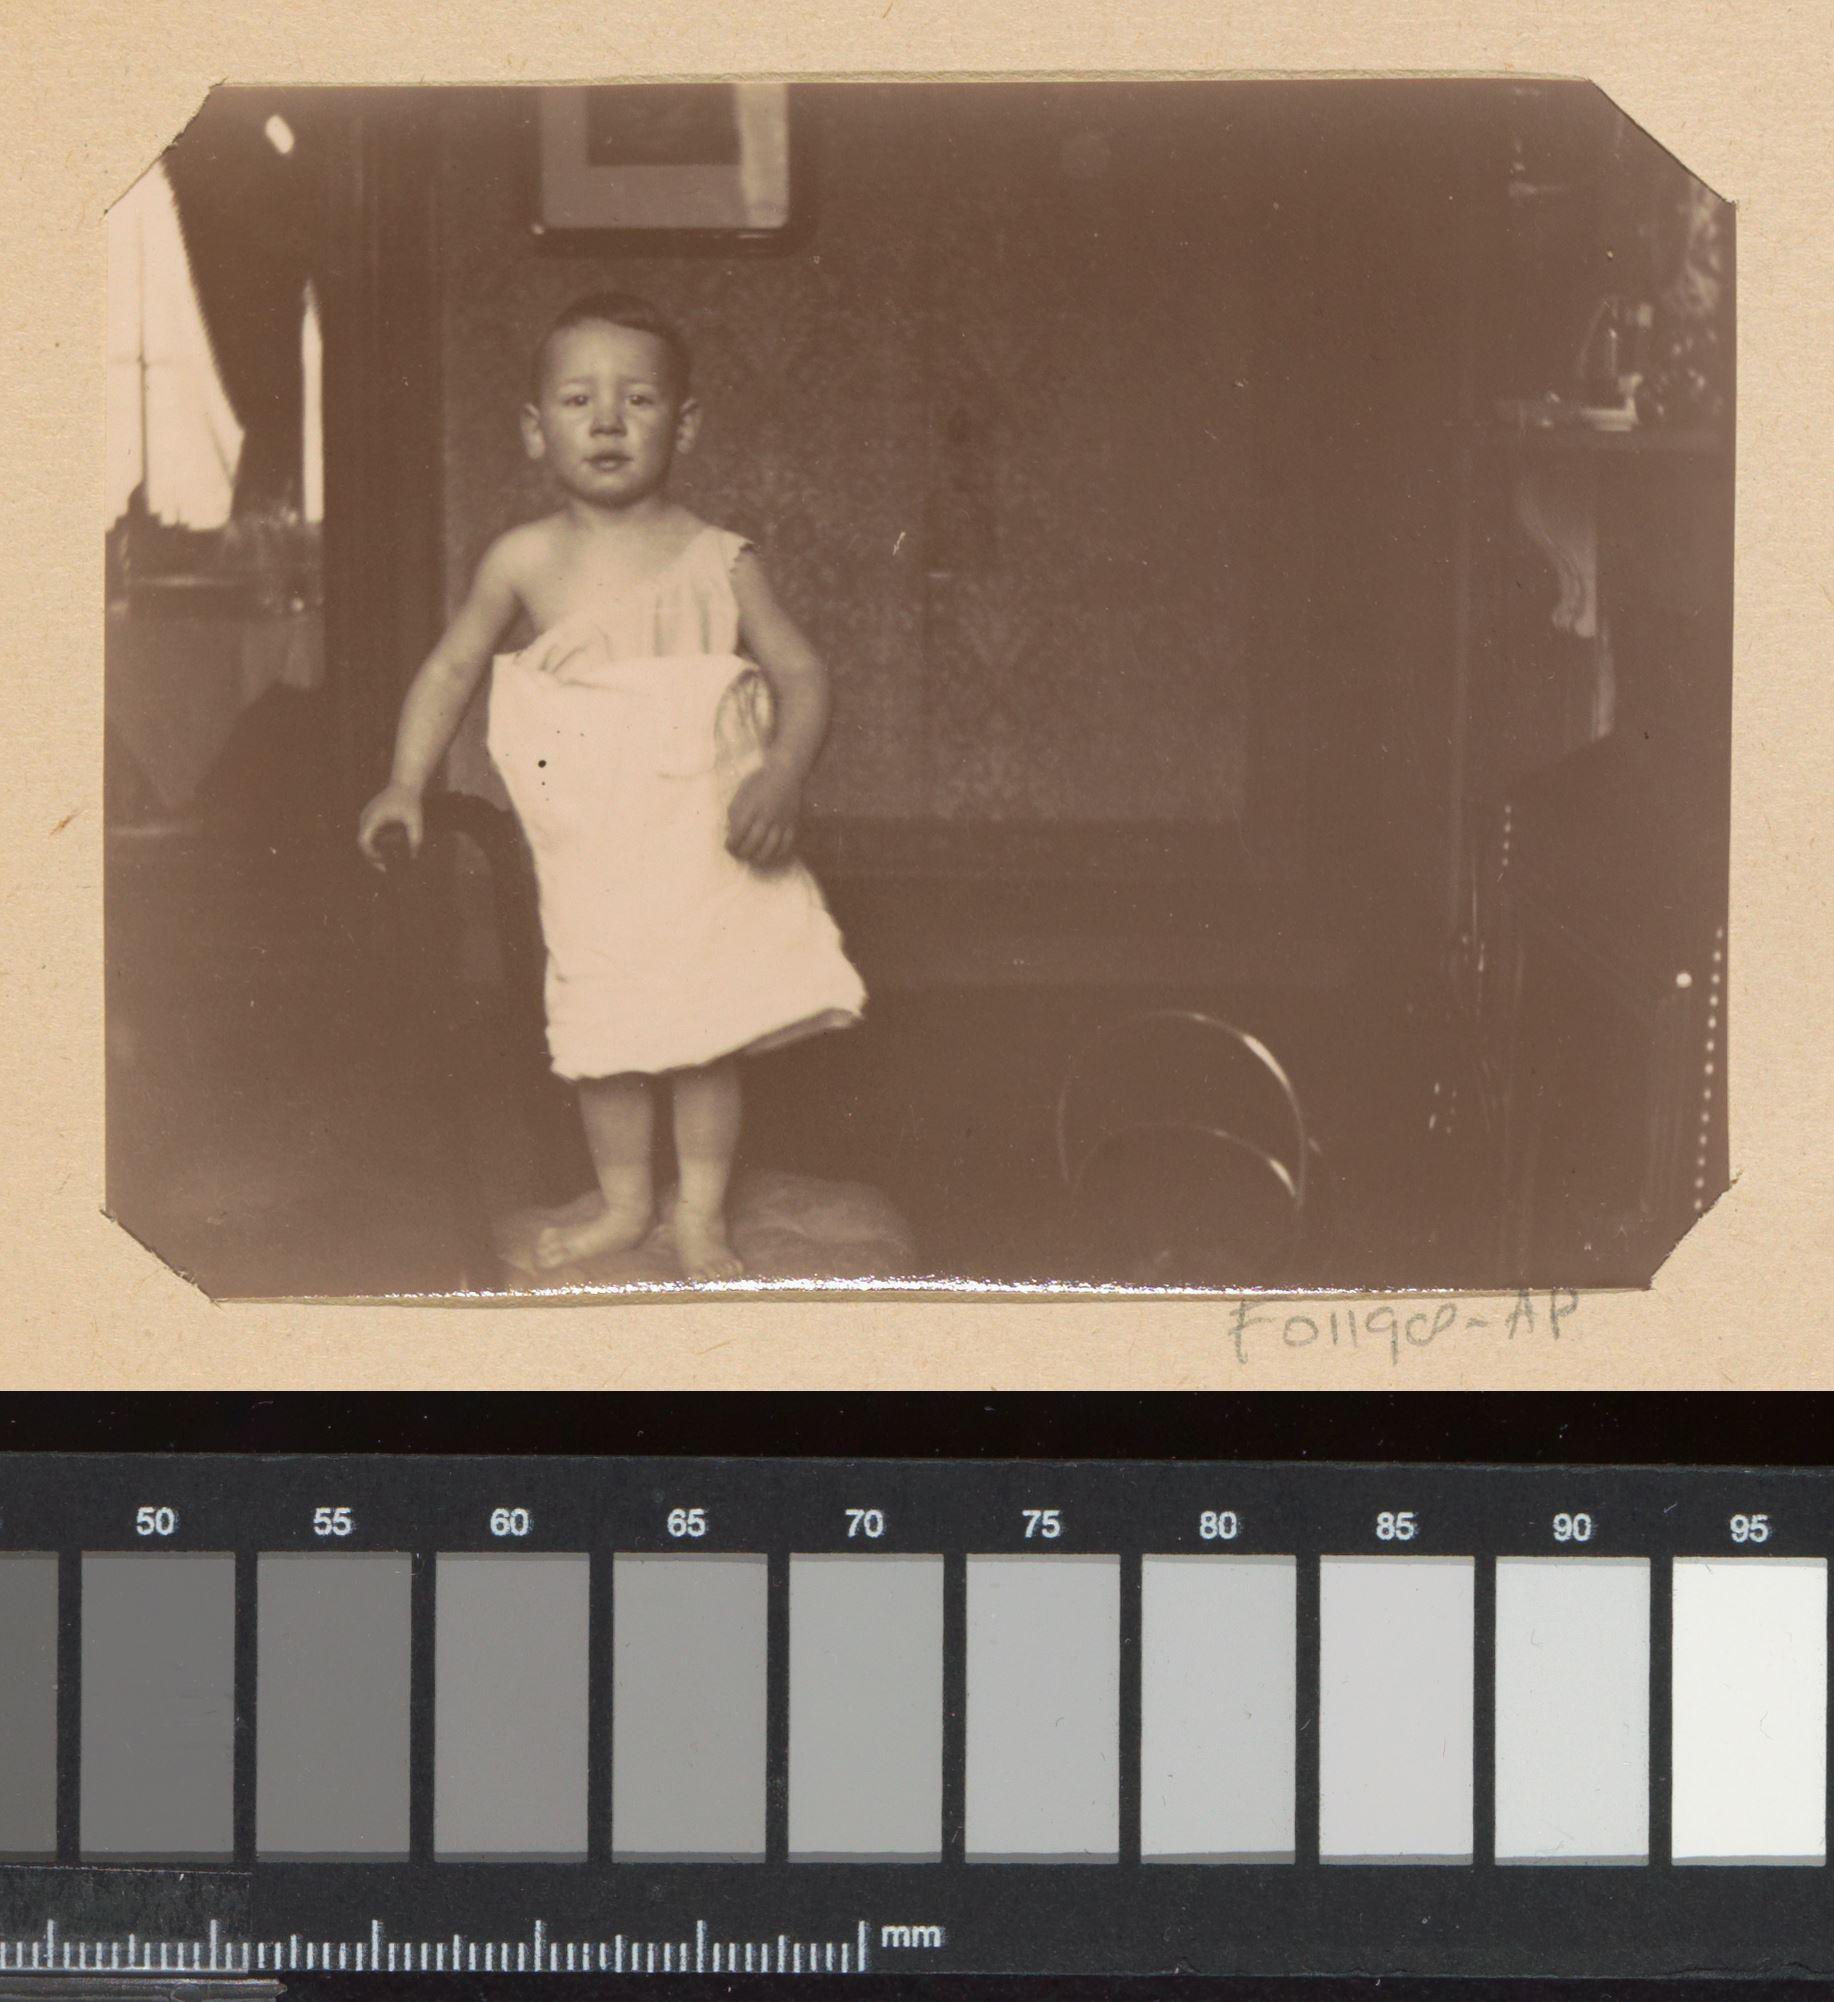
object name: photograph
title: Portret van een kleuter, mogelijk Carl of Lucia Piek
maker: johanna margaretha piek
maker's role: fotograaf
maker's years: 1870-1947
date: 1889-1893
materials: paper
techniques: gelatin silver print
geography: netherlands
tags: toddler, historical persons, netherlands